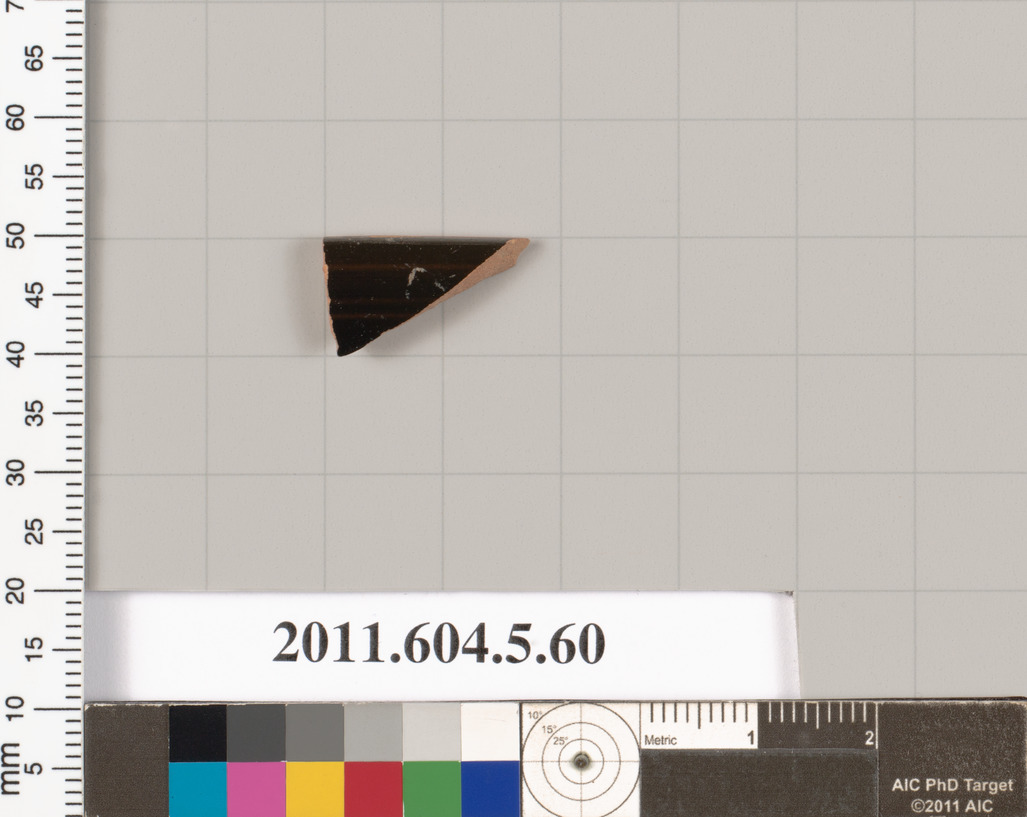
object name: kylix fragment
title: Terracotta rim fragment of a kylix (drinking cup)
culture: greek, attic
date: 500-401 BCE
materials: terracotta